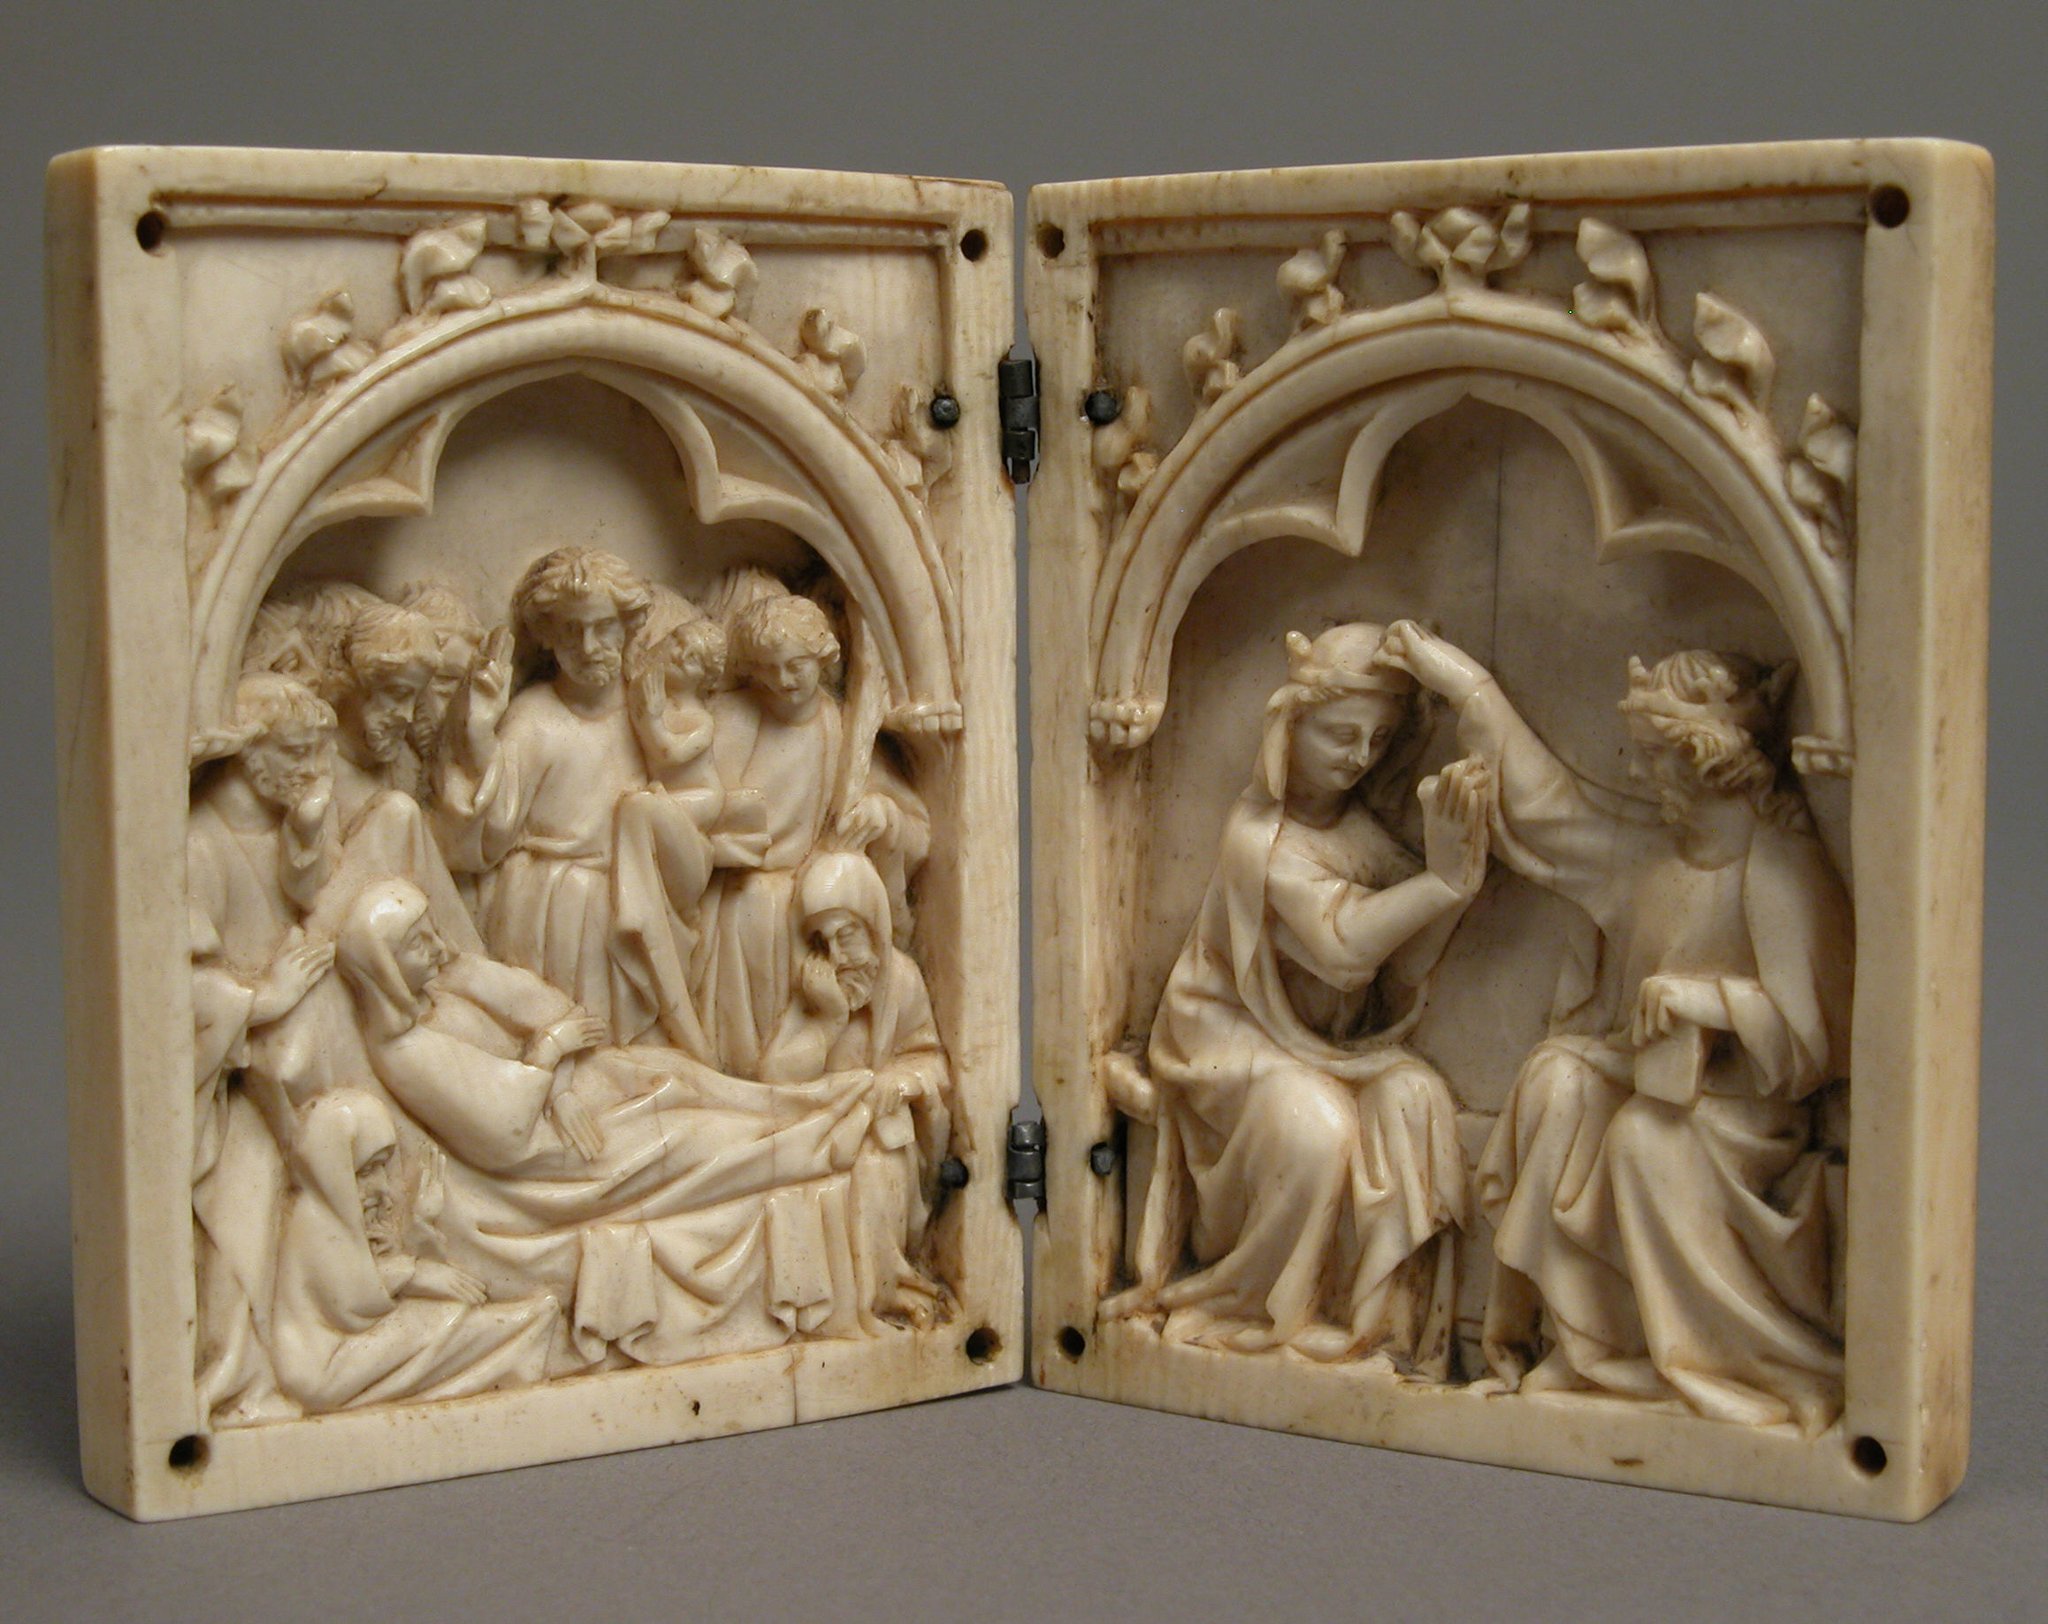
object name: diptych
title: Diptych with the Death and Coronation of the Virgin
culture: french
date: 1330-1350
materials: ivory, metal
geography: france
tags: men,women,death